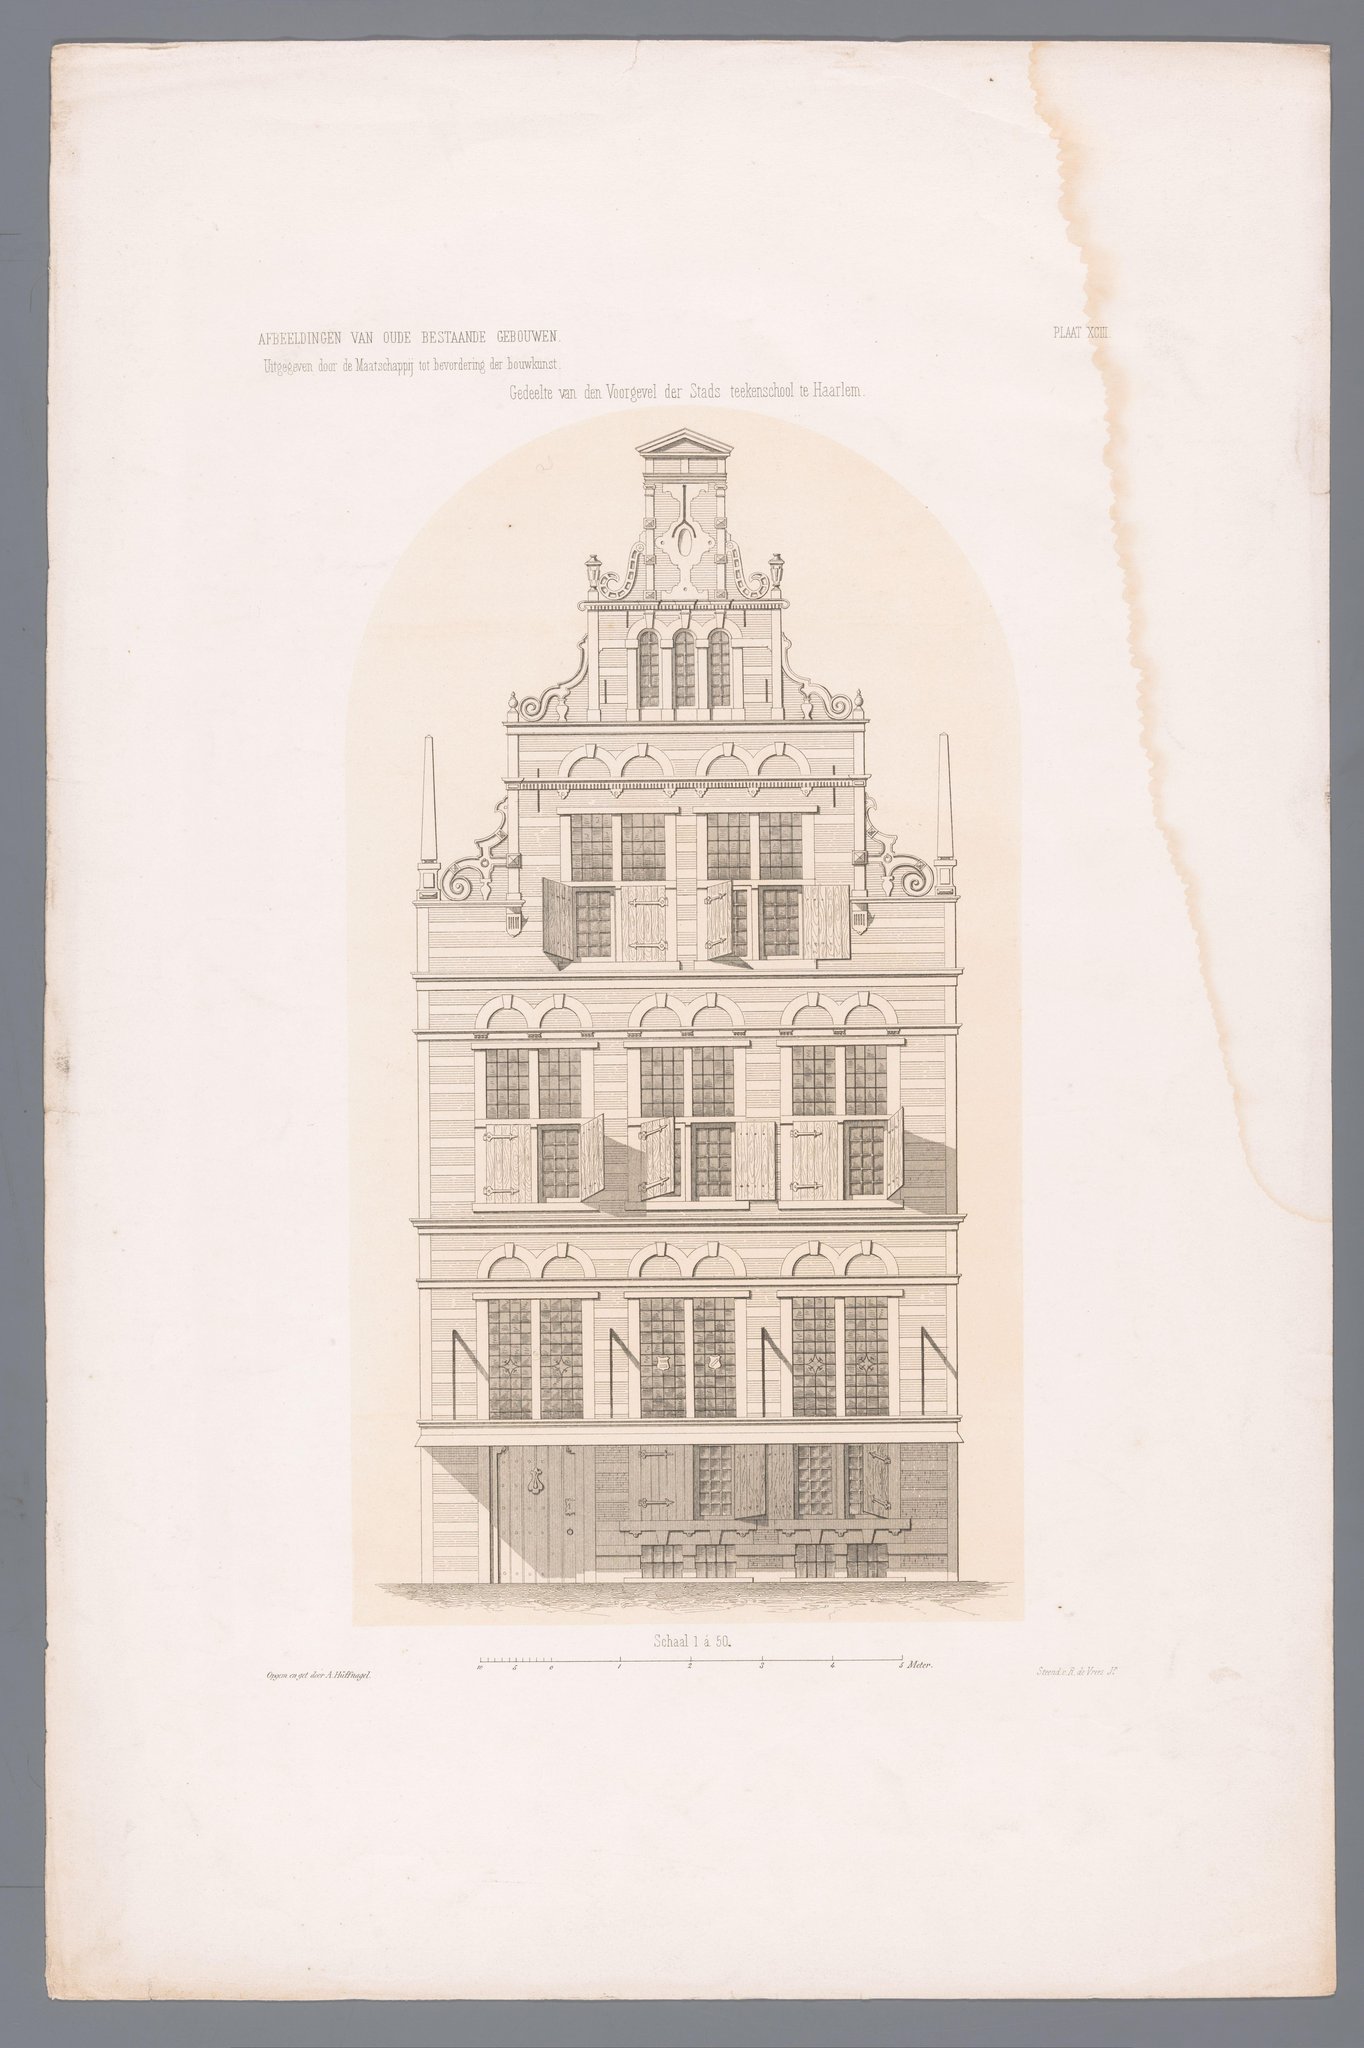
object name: print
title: Gedeelte van den Voorgevel der Stads teekenschool te Haarlem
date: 1842-1919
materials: paper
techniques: tone lithography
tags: architectural design or model, haarlem